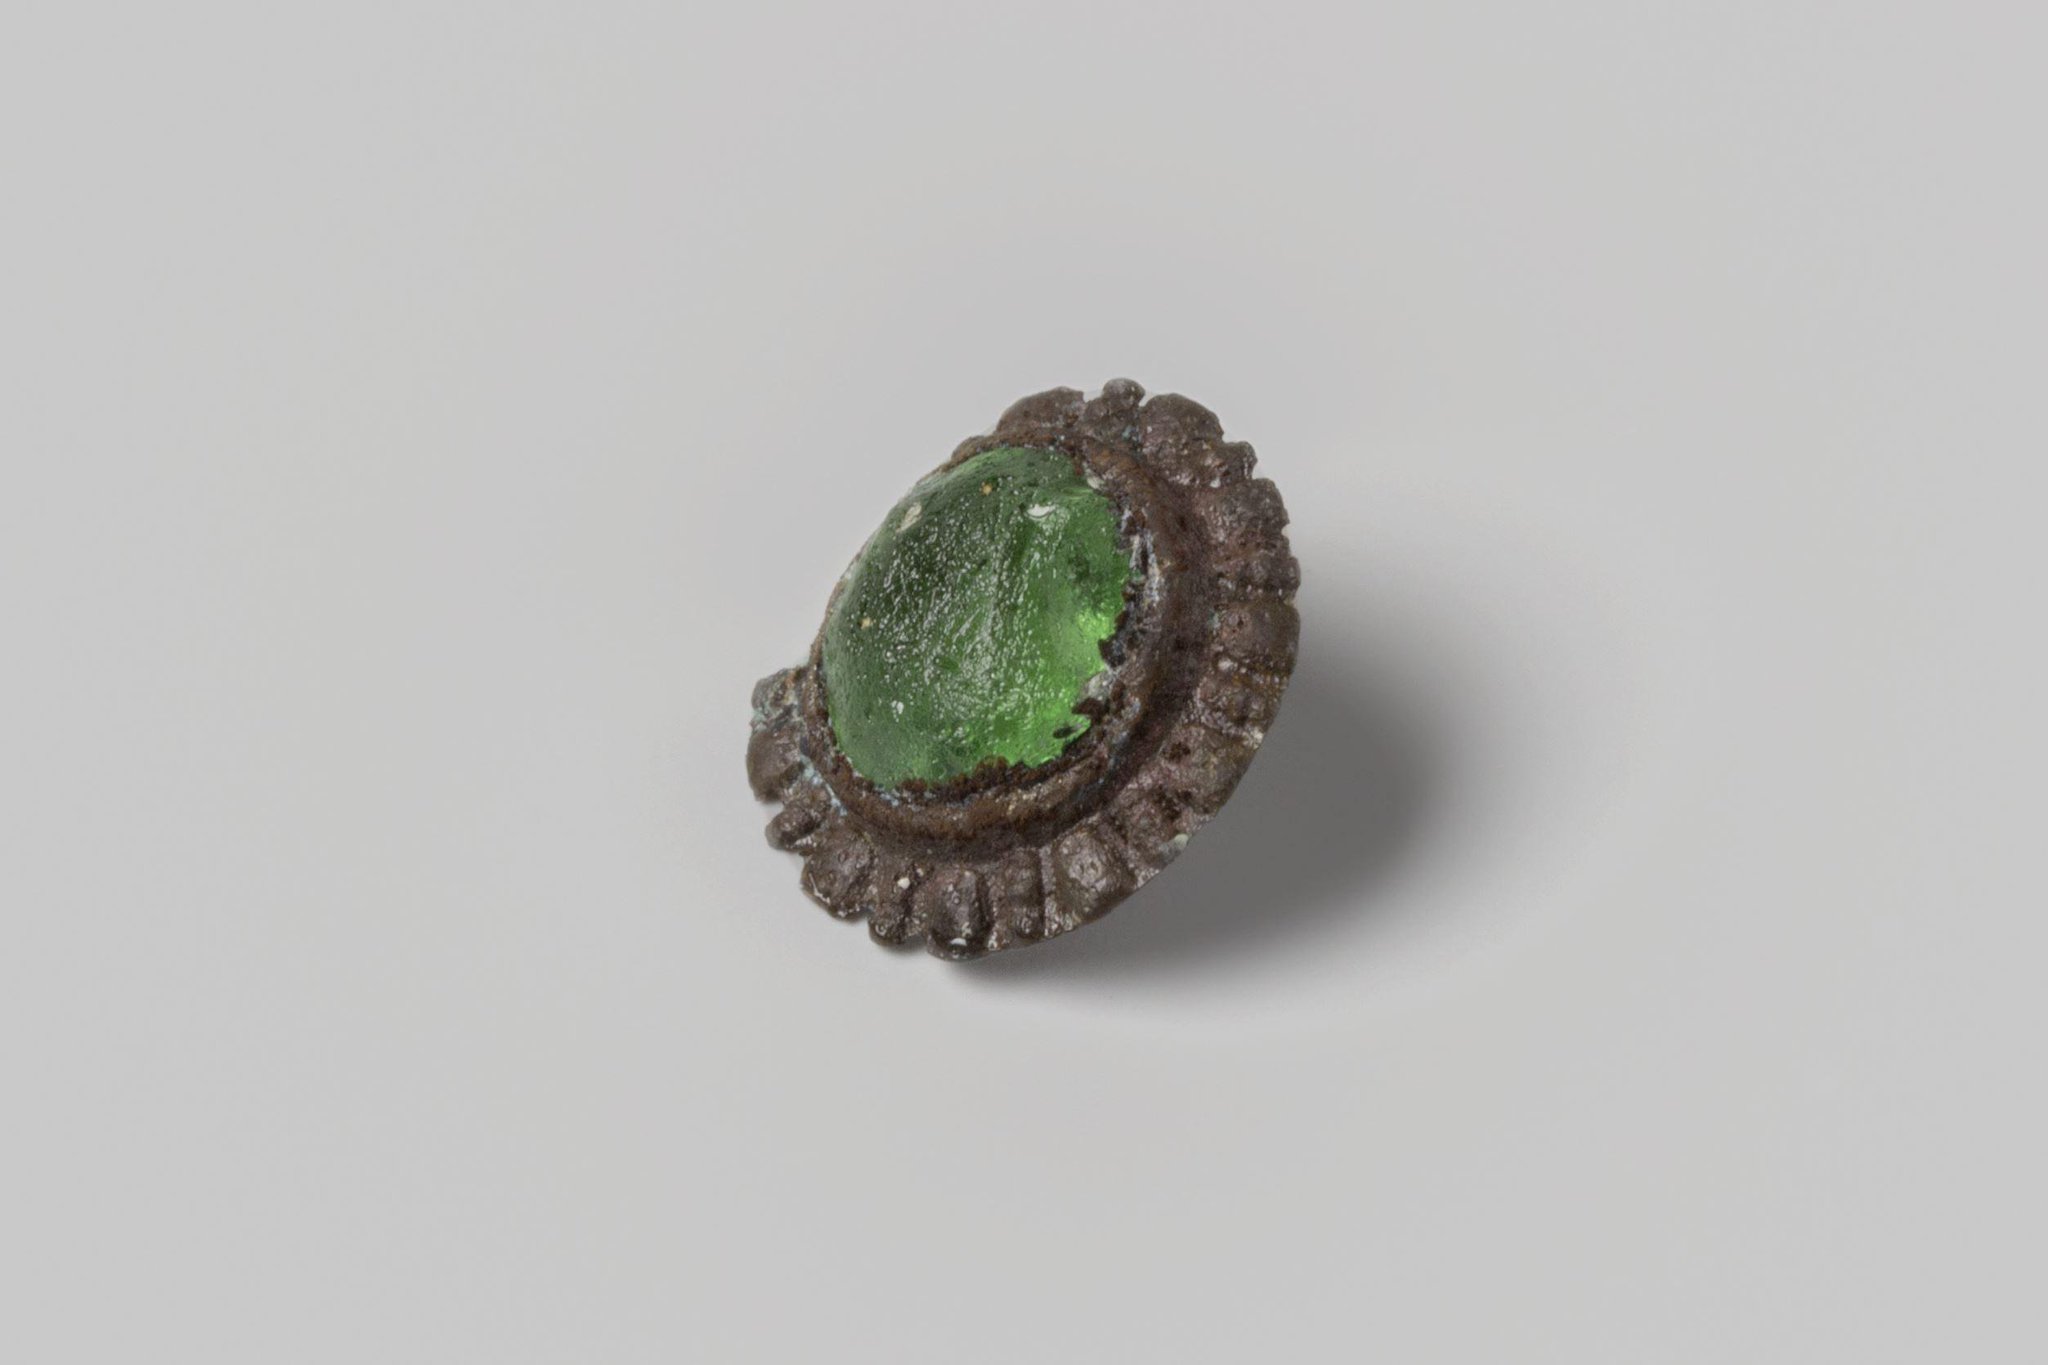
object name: button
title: Knoop uit het wrak van de Oost-Indiëvaarder Hollandia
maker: Anonymous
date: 1700-1743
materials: copper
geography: netherlands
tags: verenigde oostindische compagnie, hollandia (schip), annet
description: Knoop, met groene steen. (1) conical base, bevelled overhanging rim, ribbed (1.1d), faceted conical green stone-setting, key-shank